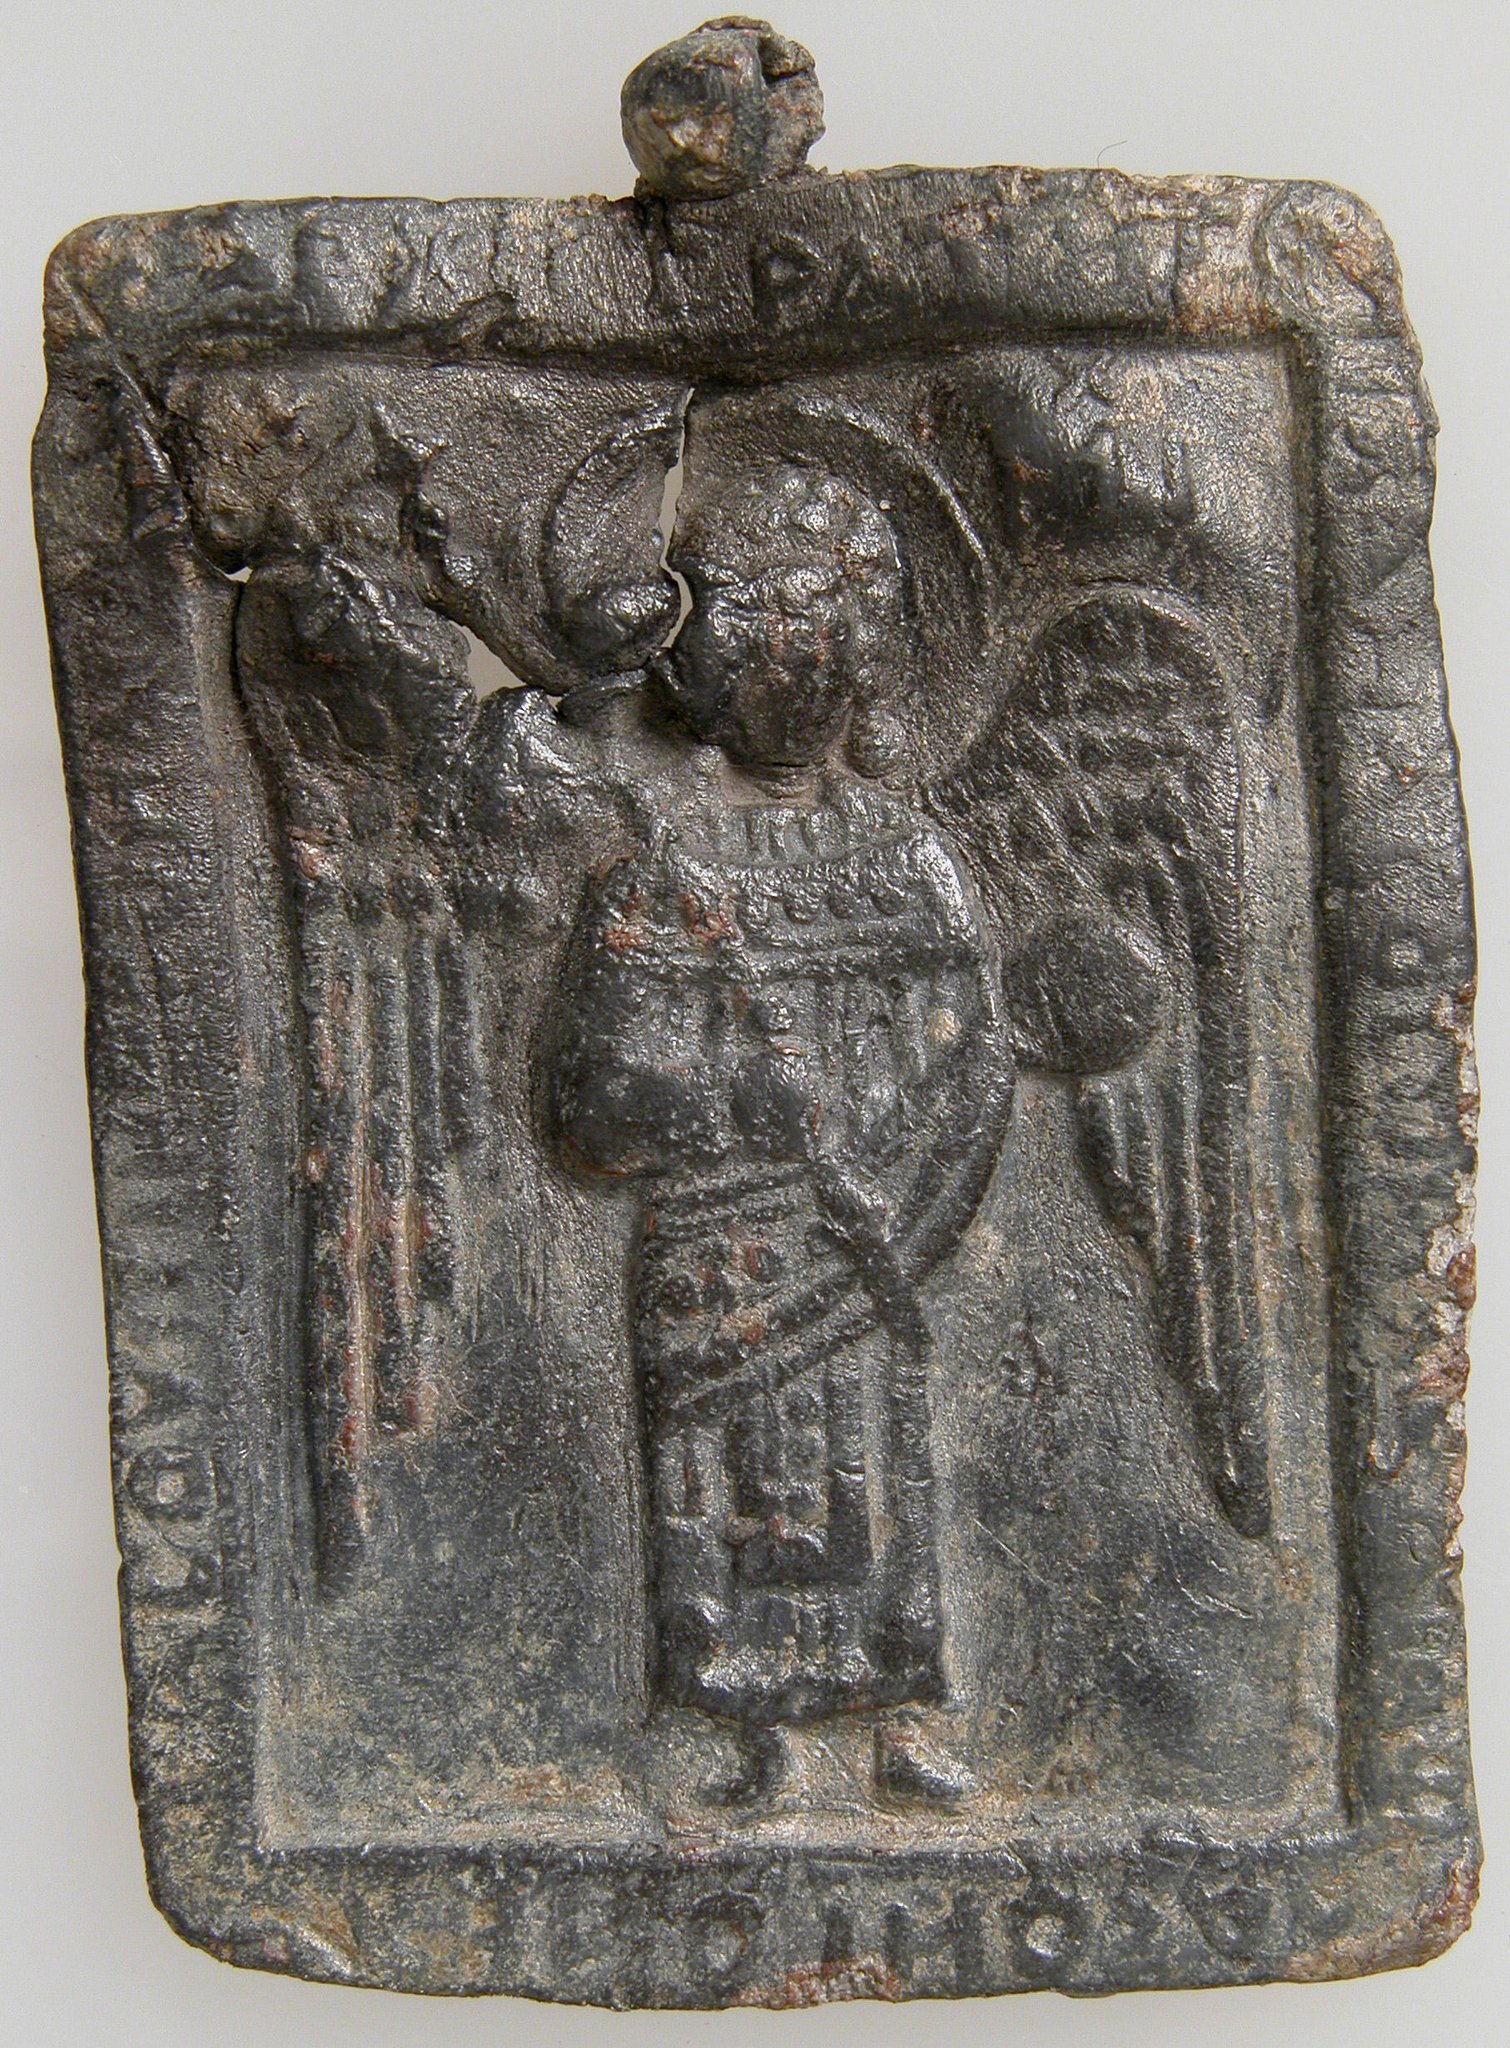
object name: pendant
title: Icon Pendant with the Archangel Michael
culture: byzantine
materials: lead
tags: saints